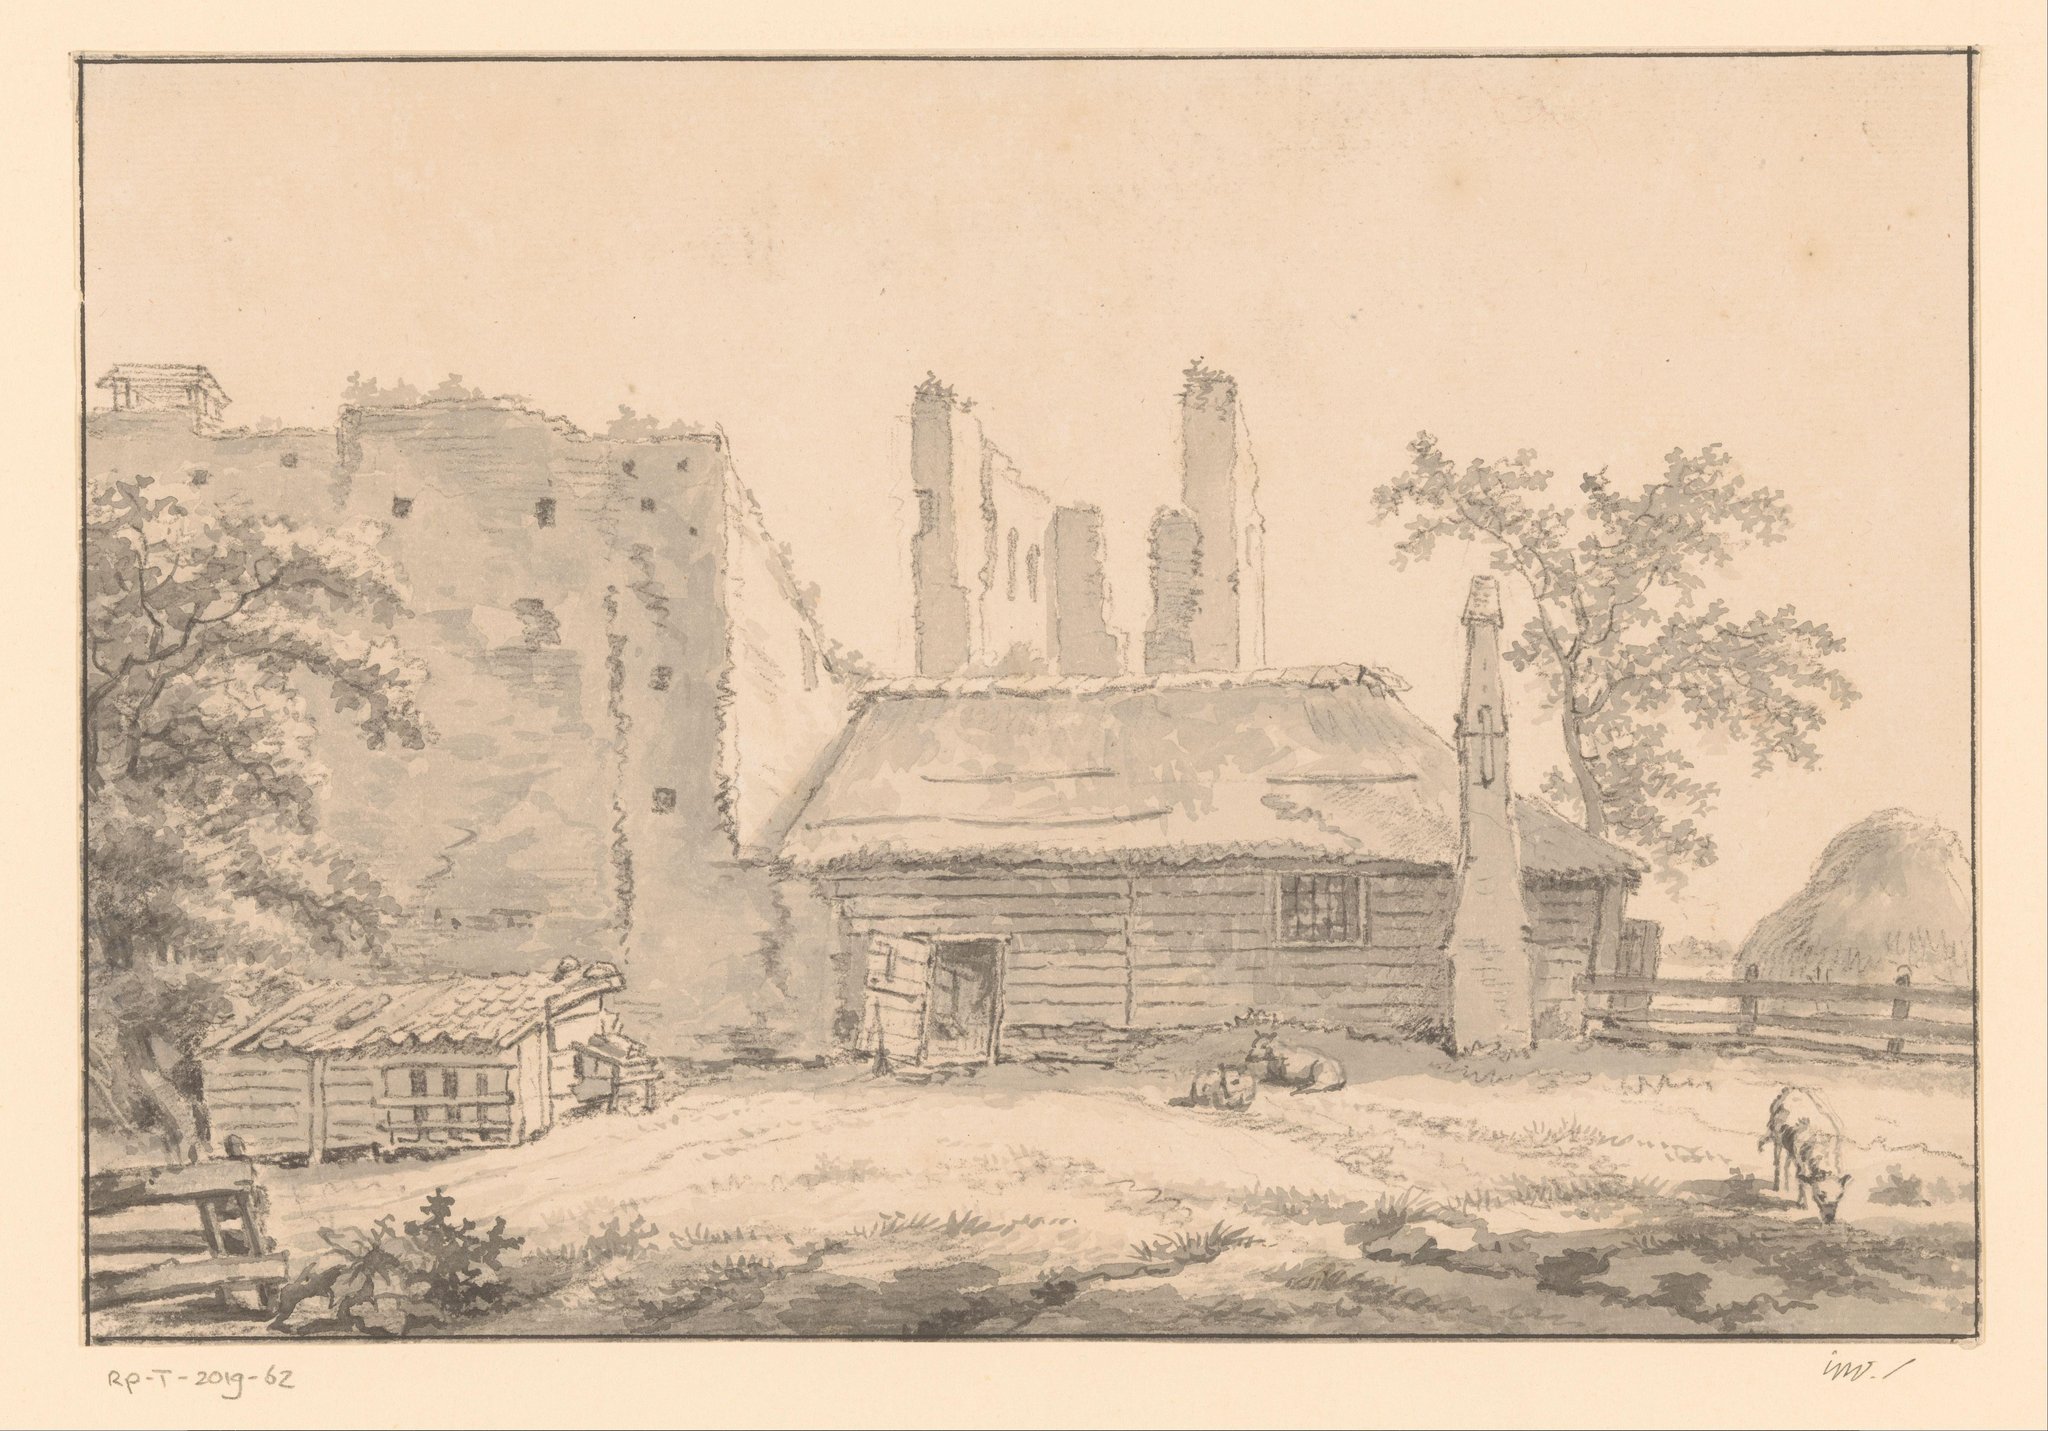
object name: drawing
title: Gezicht op de ruïnes van Kasteel Brederode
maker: Anonymous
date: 1750-1850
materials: chalk, ink, paper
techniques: brush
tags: ruin of a dwelling, house, castle, etc.